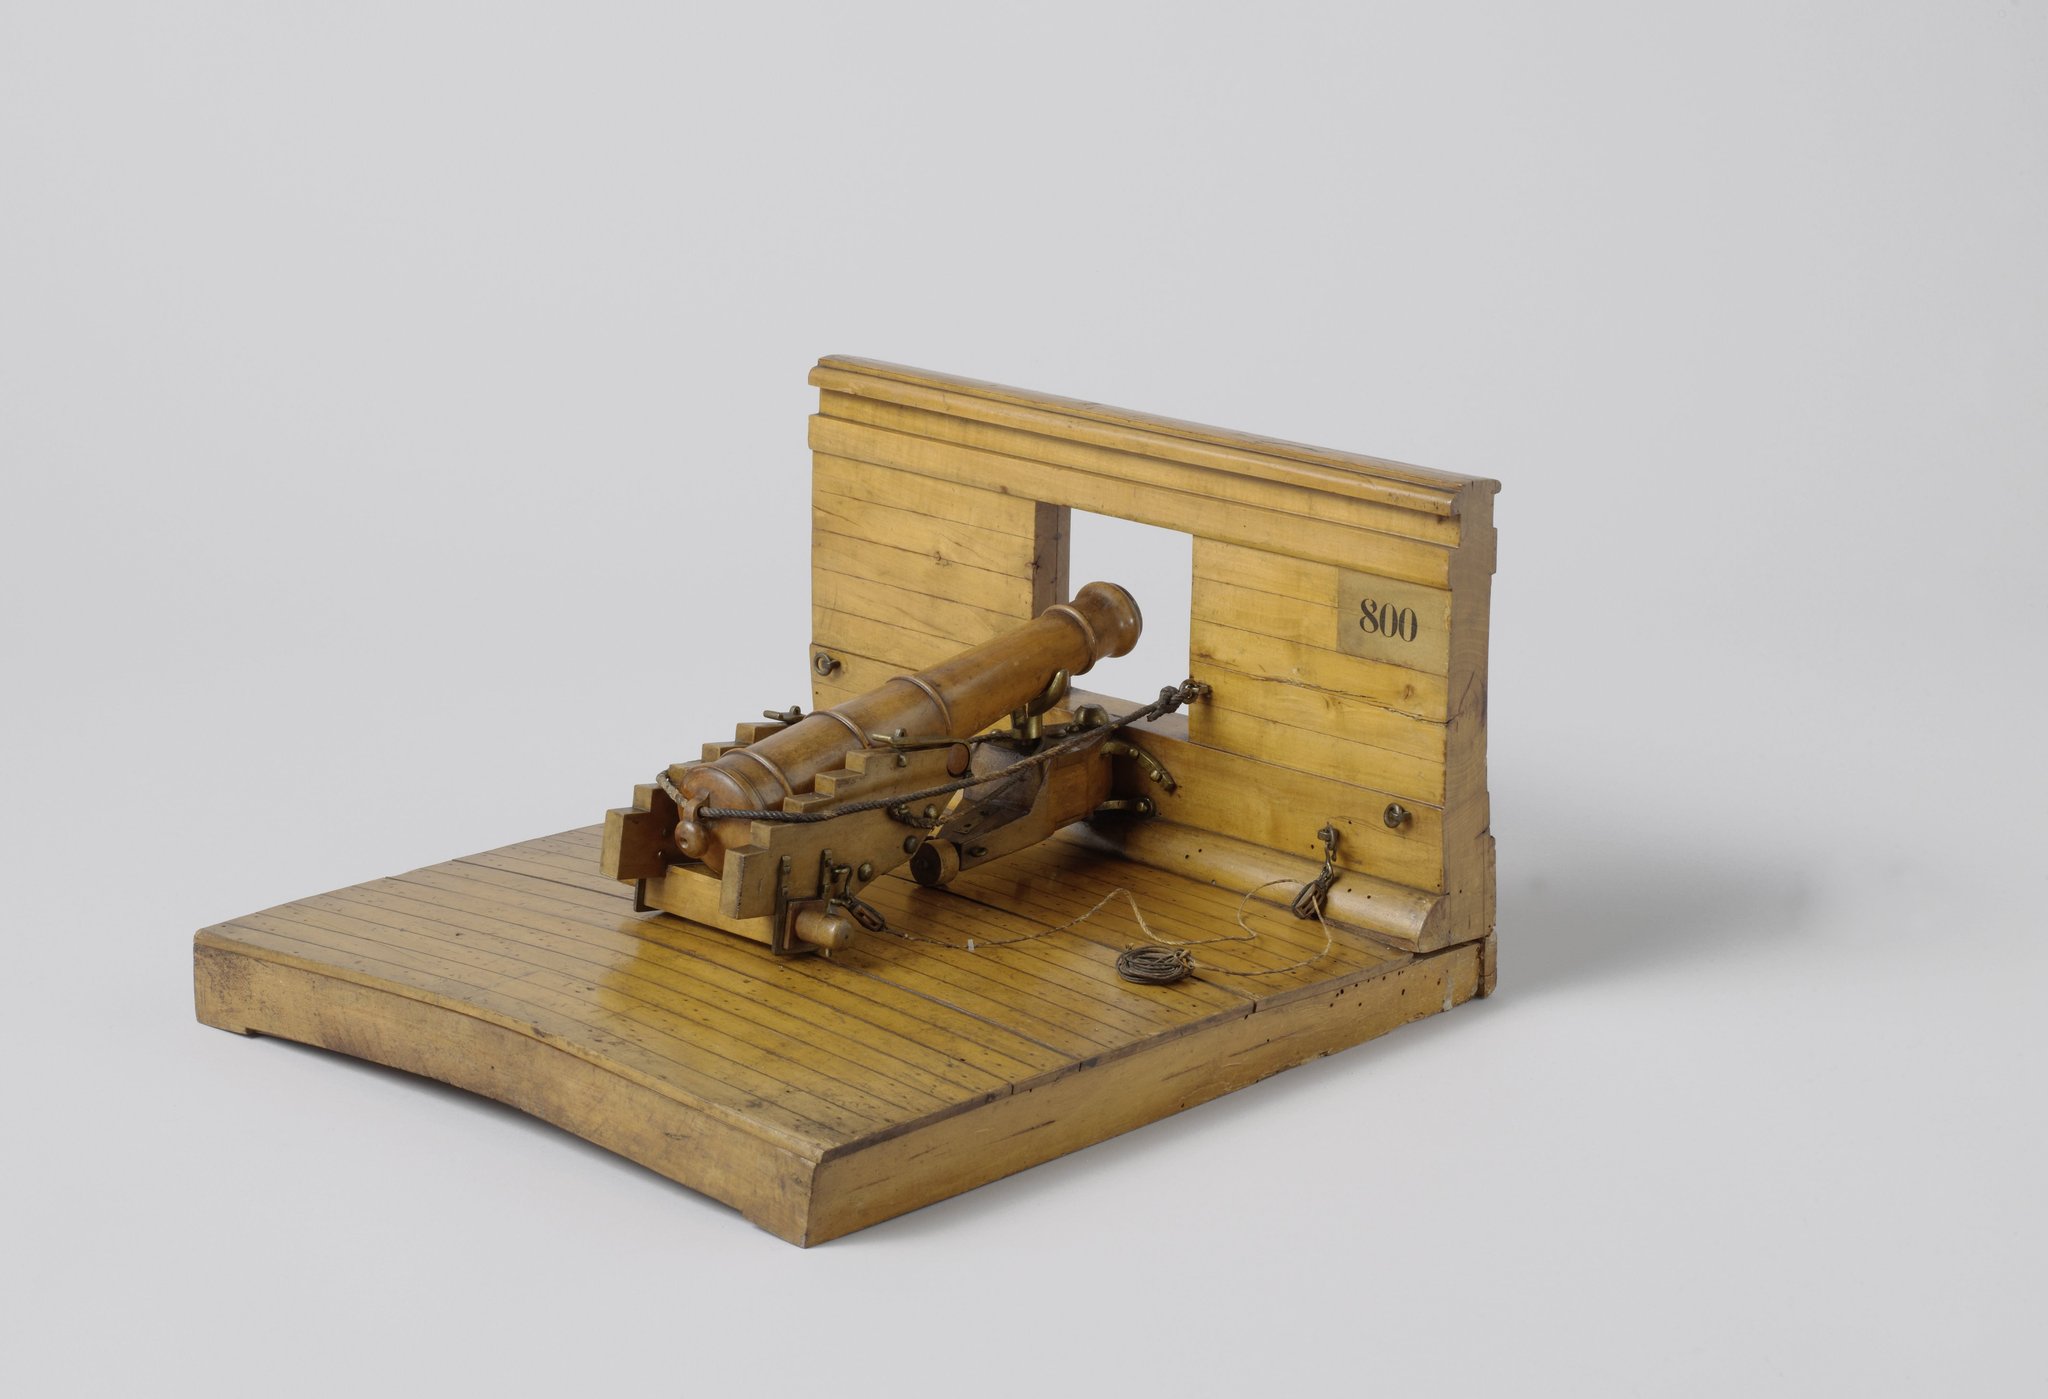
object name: demonstration model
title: Model of a 30-Pounder Gun on Deck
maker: Anonymous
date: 1827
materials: brass, fiber, wood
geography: netherlands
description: Dit type affuit, ontworpen in 1827, trok in 1828 de aandacht vanwege het grote schietveld dat hiermee mogelijk werd. Het werd echter afgekeurd. Dit model werd samen met model NG-MC-99 aangeboden om te laten zien hoe de achterboeg van fregatten van 44 en 60 stukken konden worden verdedigd.